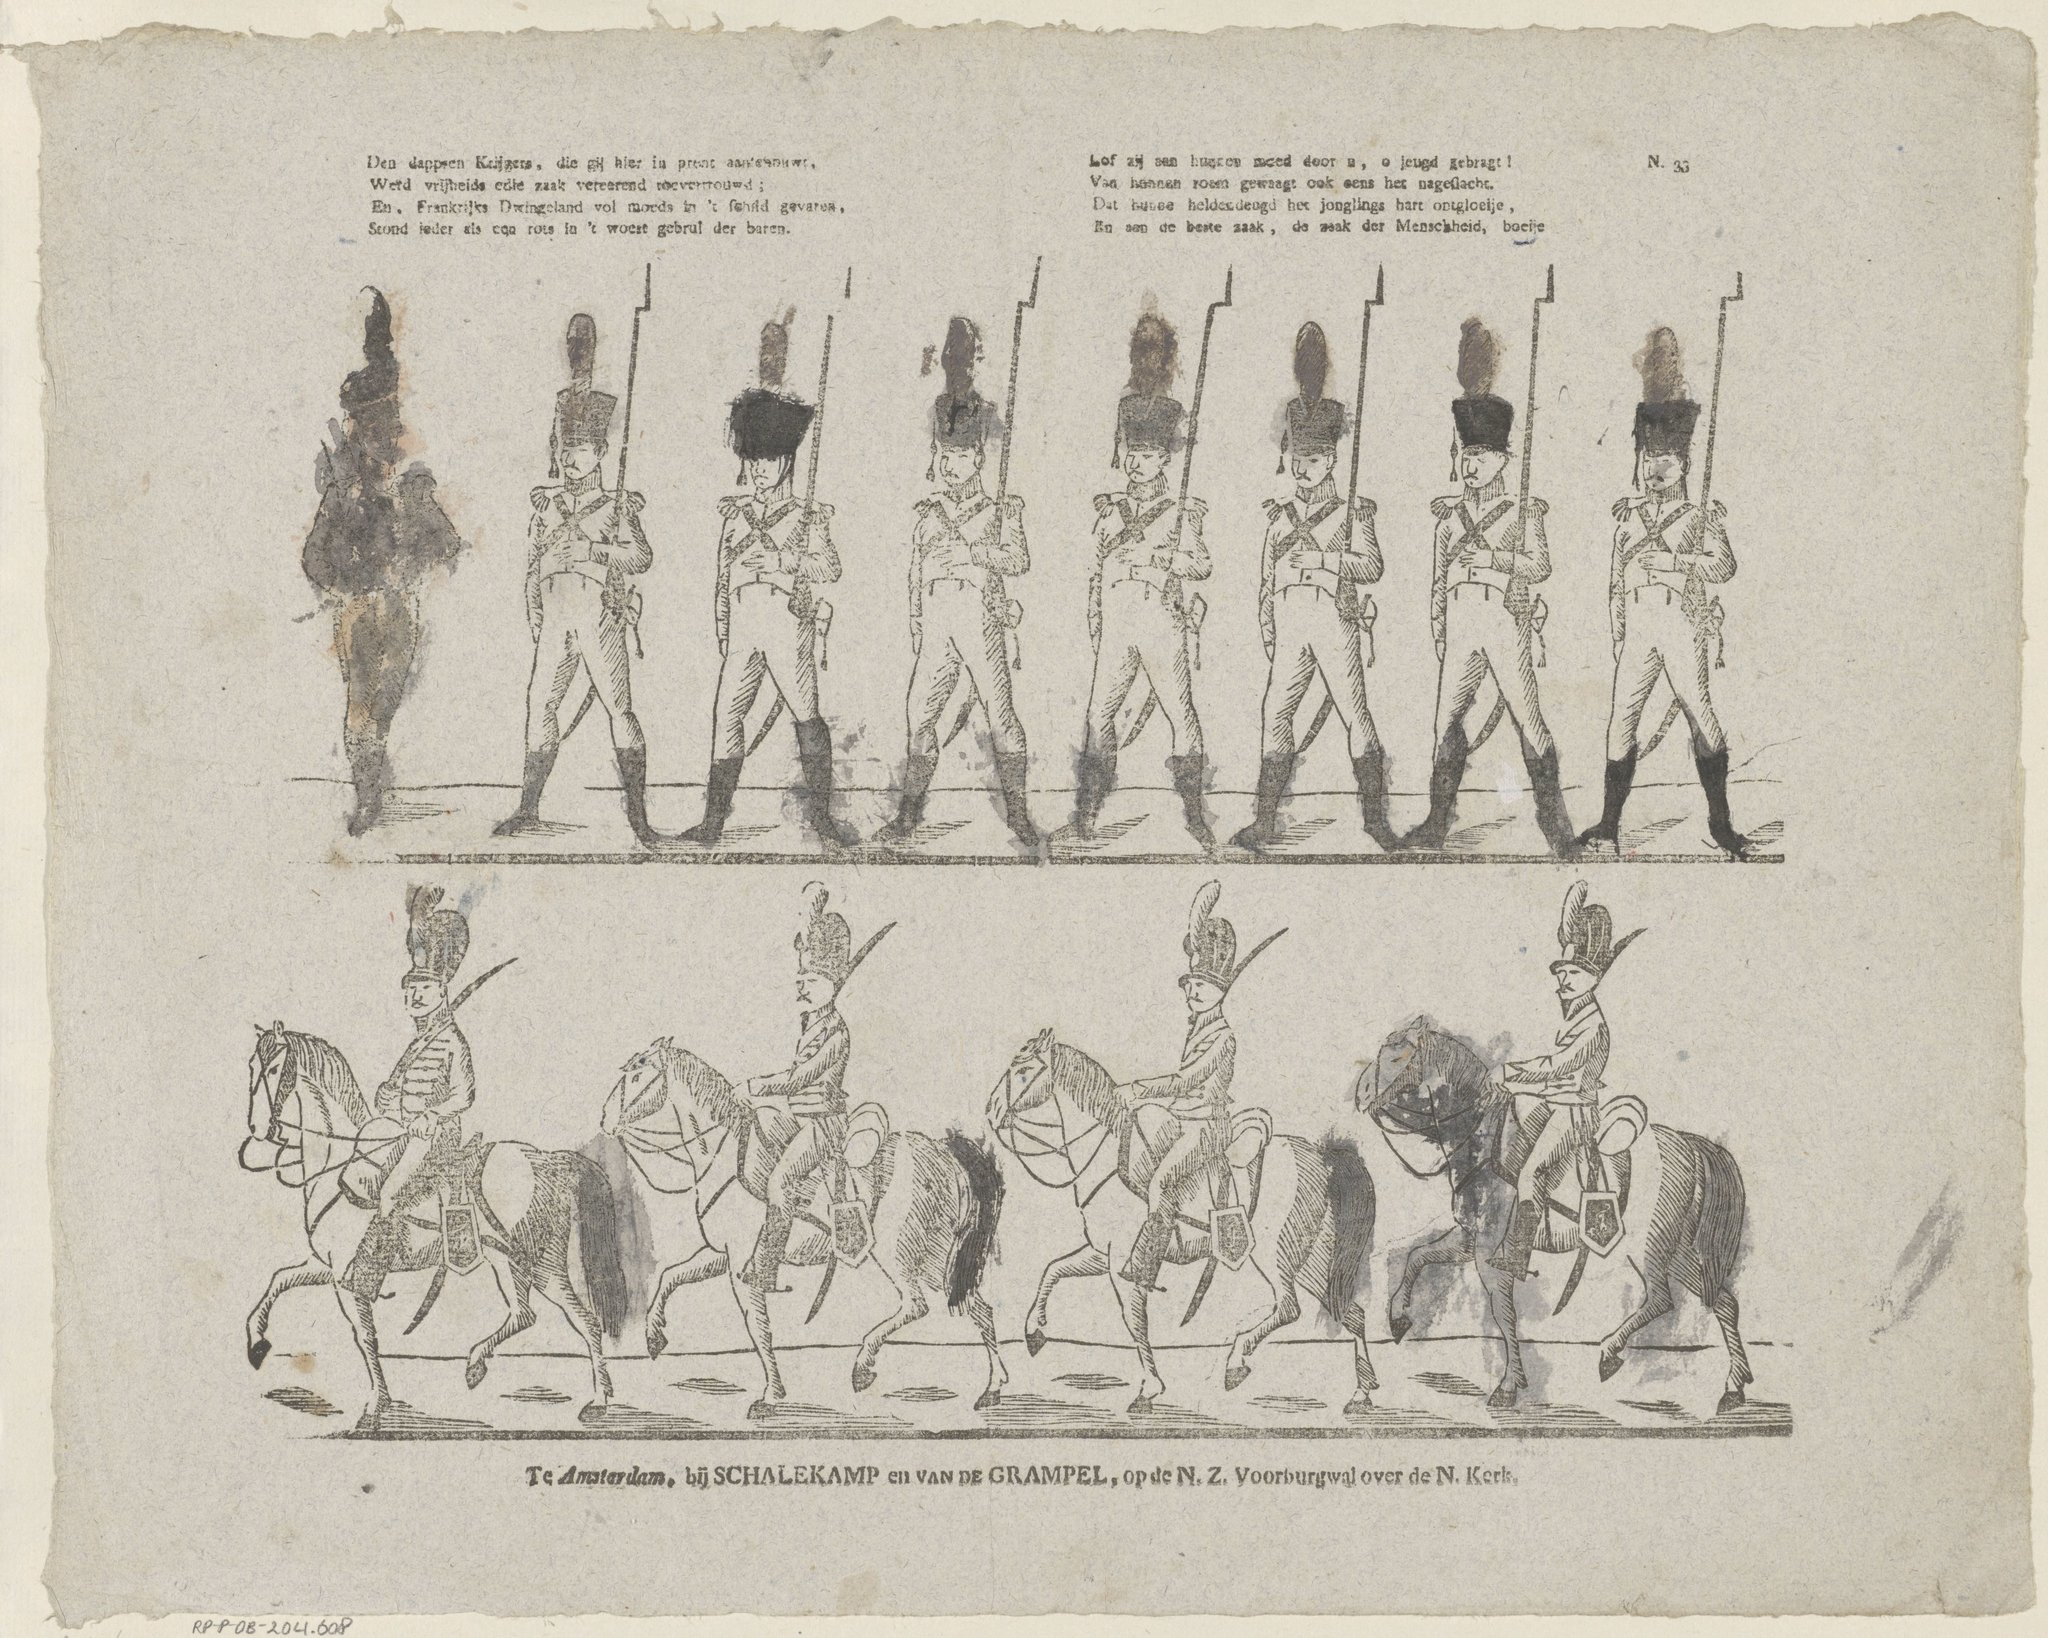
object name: popular print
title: Den dappren krijgers, die gij hier in prent aanschouwt, / Werd vrijheids edle zaak vereerend toevertrouwd [(...)]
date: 1822-1849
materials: paper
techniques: colour, letterpress printing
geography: amsterdam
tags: warfare; military affairs (+ cavalry, horsemen), the soldier; the soldier's life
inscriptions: collector's mark: Lugt 2760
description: Blad met 2 rijen met voorstellingen van militairen. Boven acht voorstellingen van voetsoldaten. Onder vier voorstellingen van militairen te paard. Genummerd rechtsboven: N. 33.